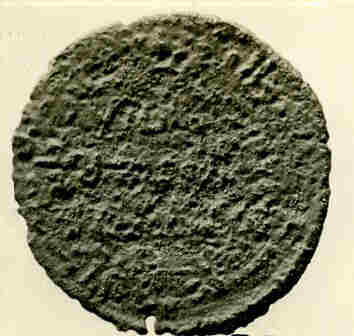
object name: coin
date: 701-900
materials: copper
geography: iran